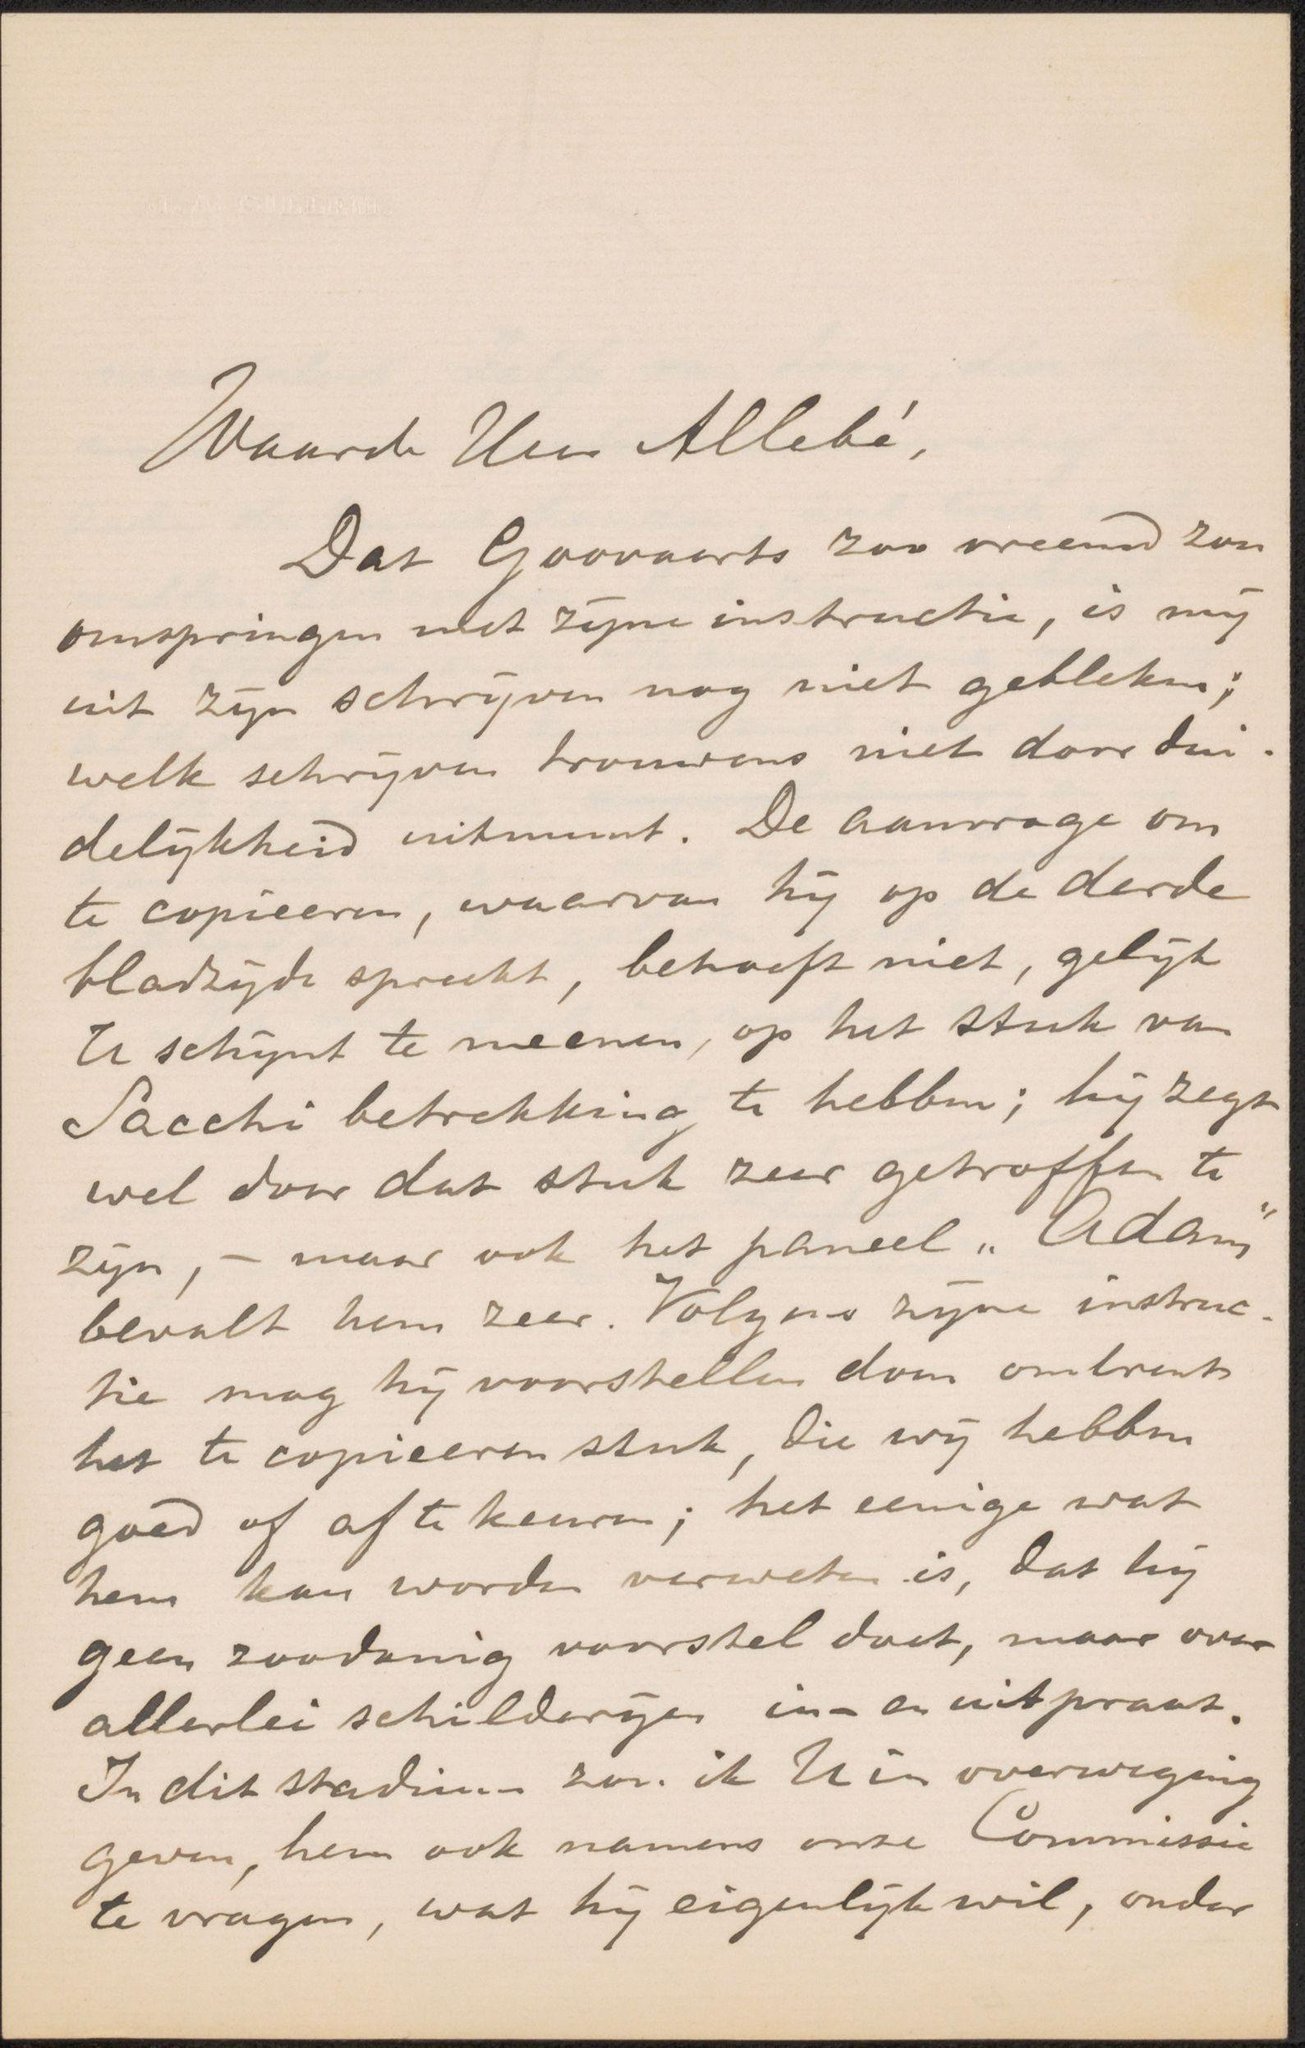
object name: letter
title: Brief aan August Allebé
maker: jérôme alexander sillem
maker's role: politician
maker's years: 1840-1912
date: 1891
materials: ink, paper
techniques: pen, printing, writing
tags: maastricht, conservator, henri goovaerts, amsterdam, print maker, draughtsman, august allebé, jac van looij, utrecht, etha fles, criticizing and discussing art, art criticism, painting (including book-illumination, miniature-painting), italy, spain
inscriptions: name: ‘J.A. SILLEM’